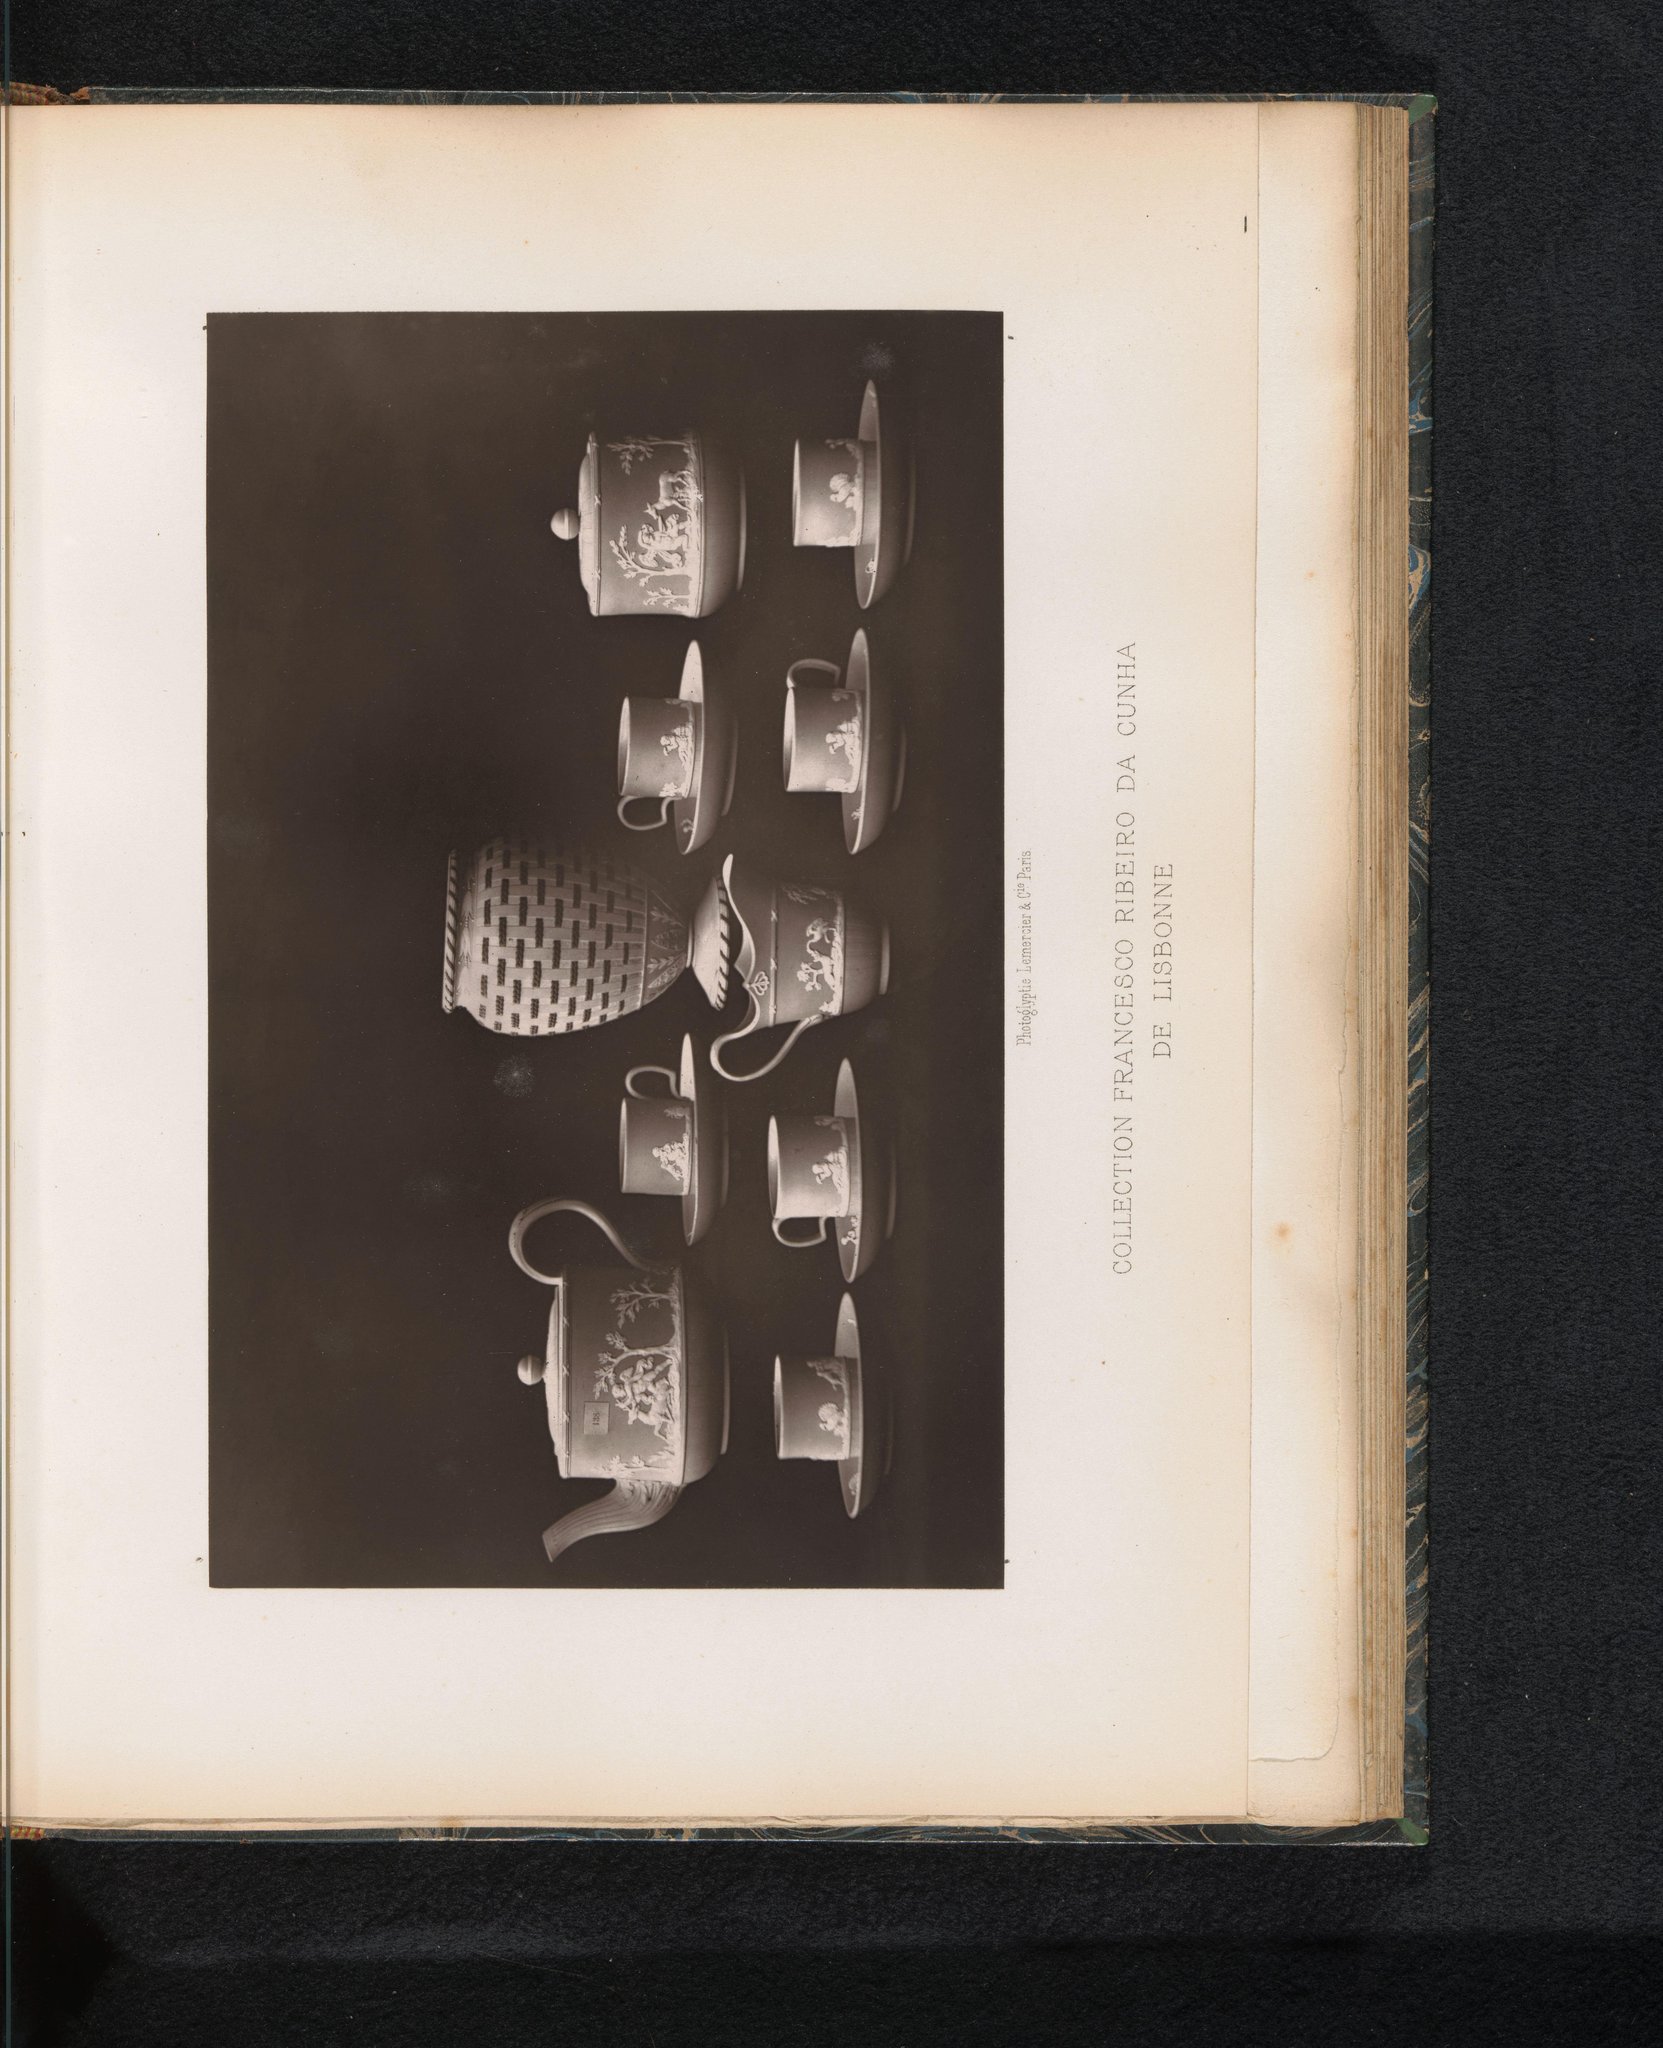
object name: page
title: Theeservies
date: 1879-1884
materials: paper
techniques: woodburytype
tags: tea- and coffee-service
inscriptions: inscription: ‘Collection Francesco Riberio da Cunha de Lisbonne’